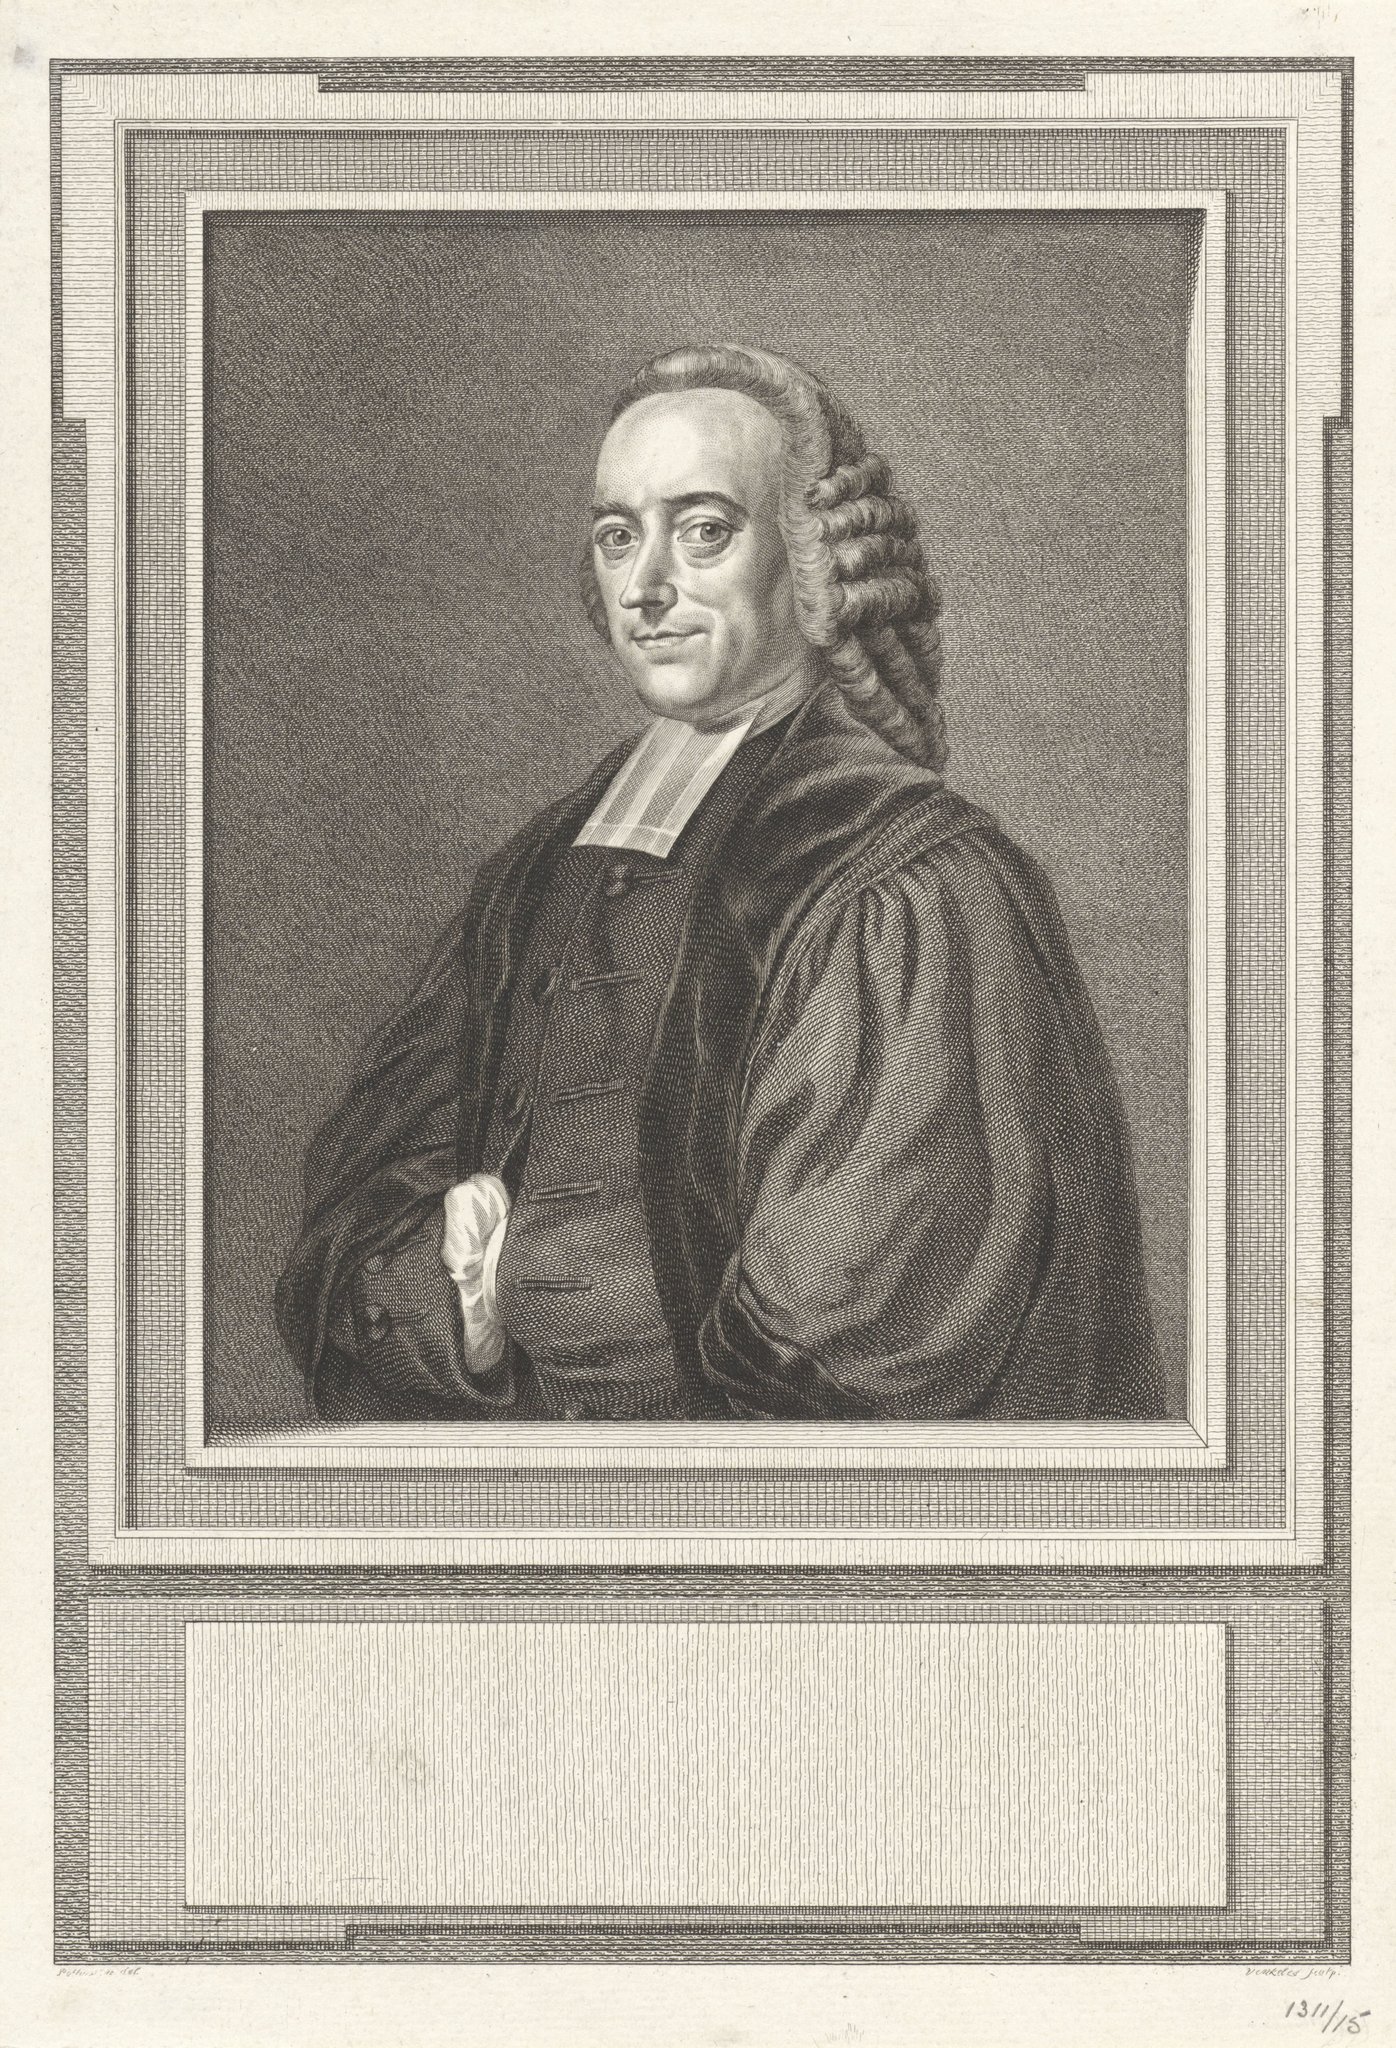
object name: print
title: Portret van de predikant Gerard Johan Nahuys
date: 1781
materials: paper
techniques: engraving, etching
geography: amsterdam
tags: utrecht, leiden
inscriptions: collector's mark: Lugt 240